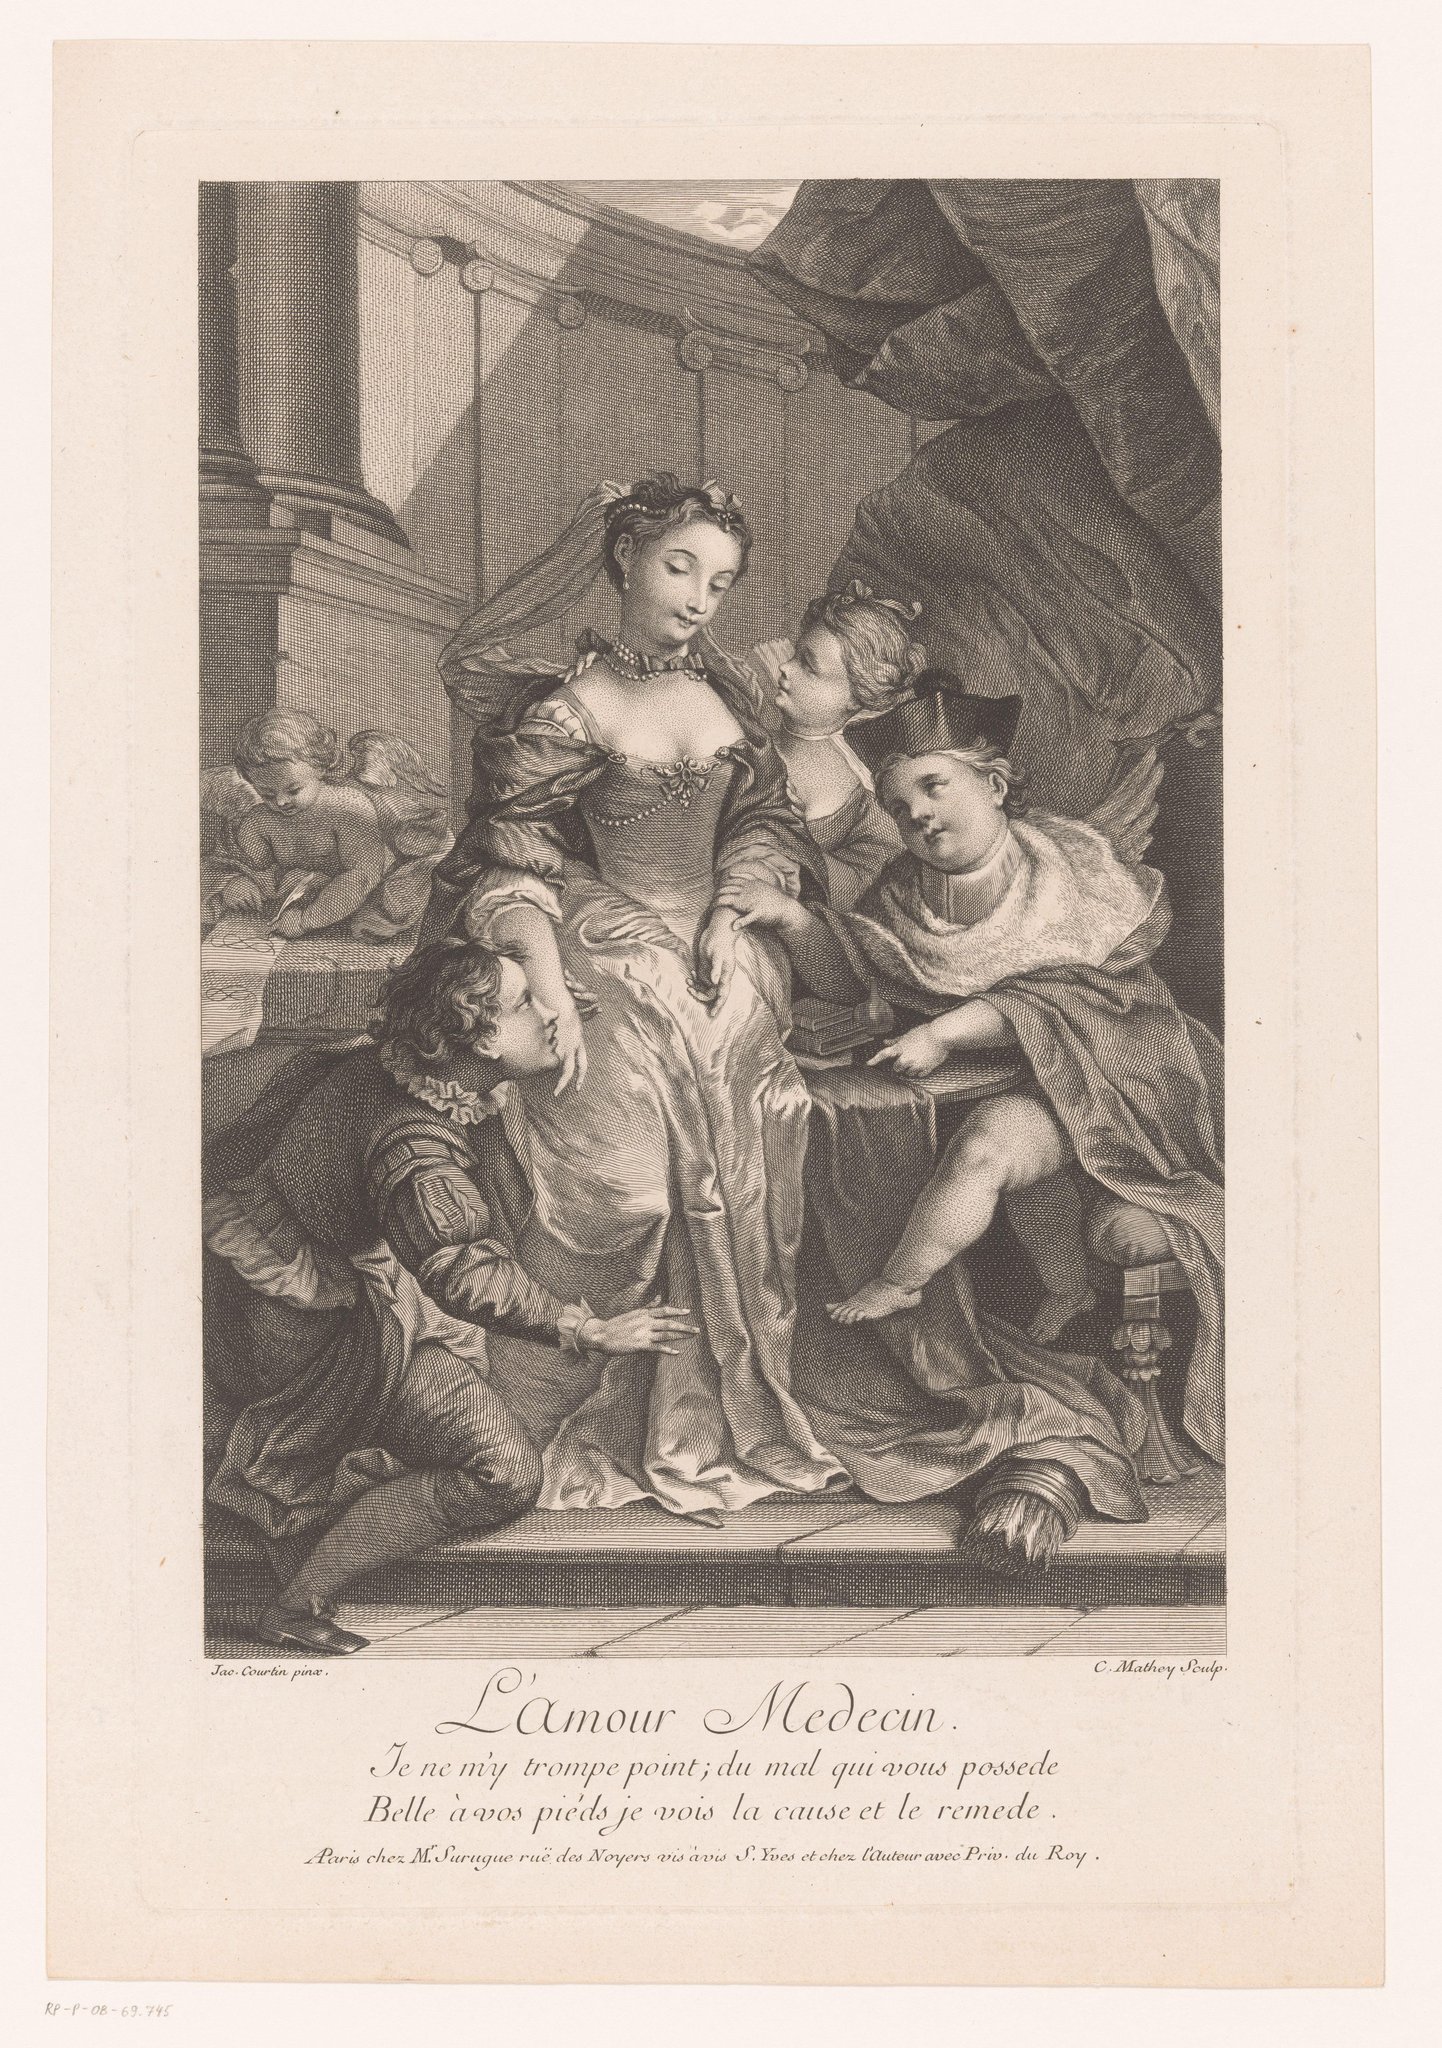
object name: print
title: L'Amour Medecin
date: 1700-1755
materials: paper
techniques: engraving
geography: paris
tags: standing figure - aa - female human figure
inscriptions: collector's mark: Lugt 2228